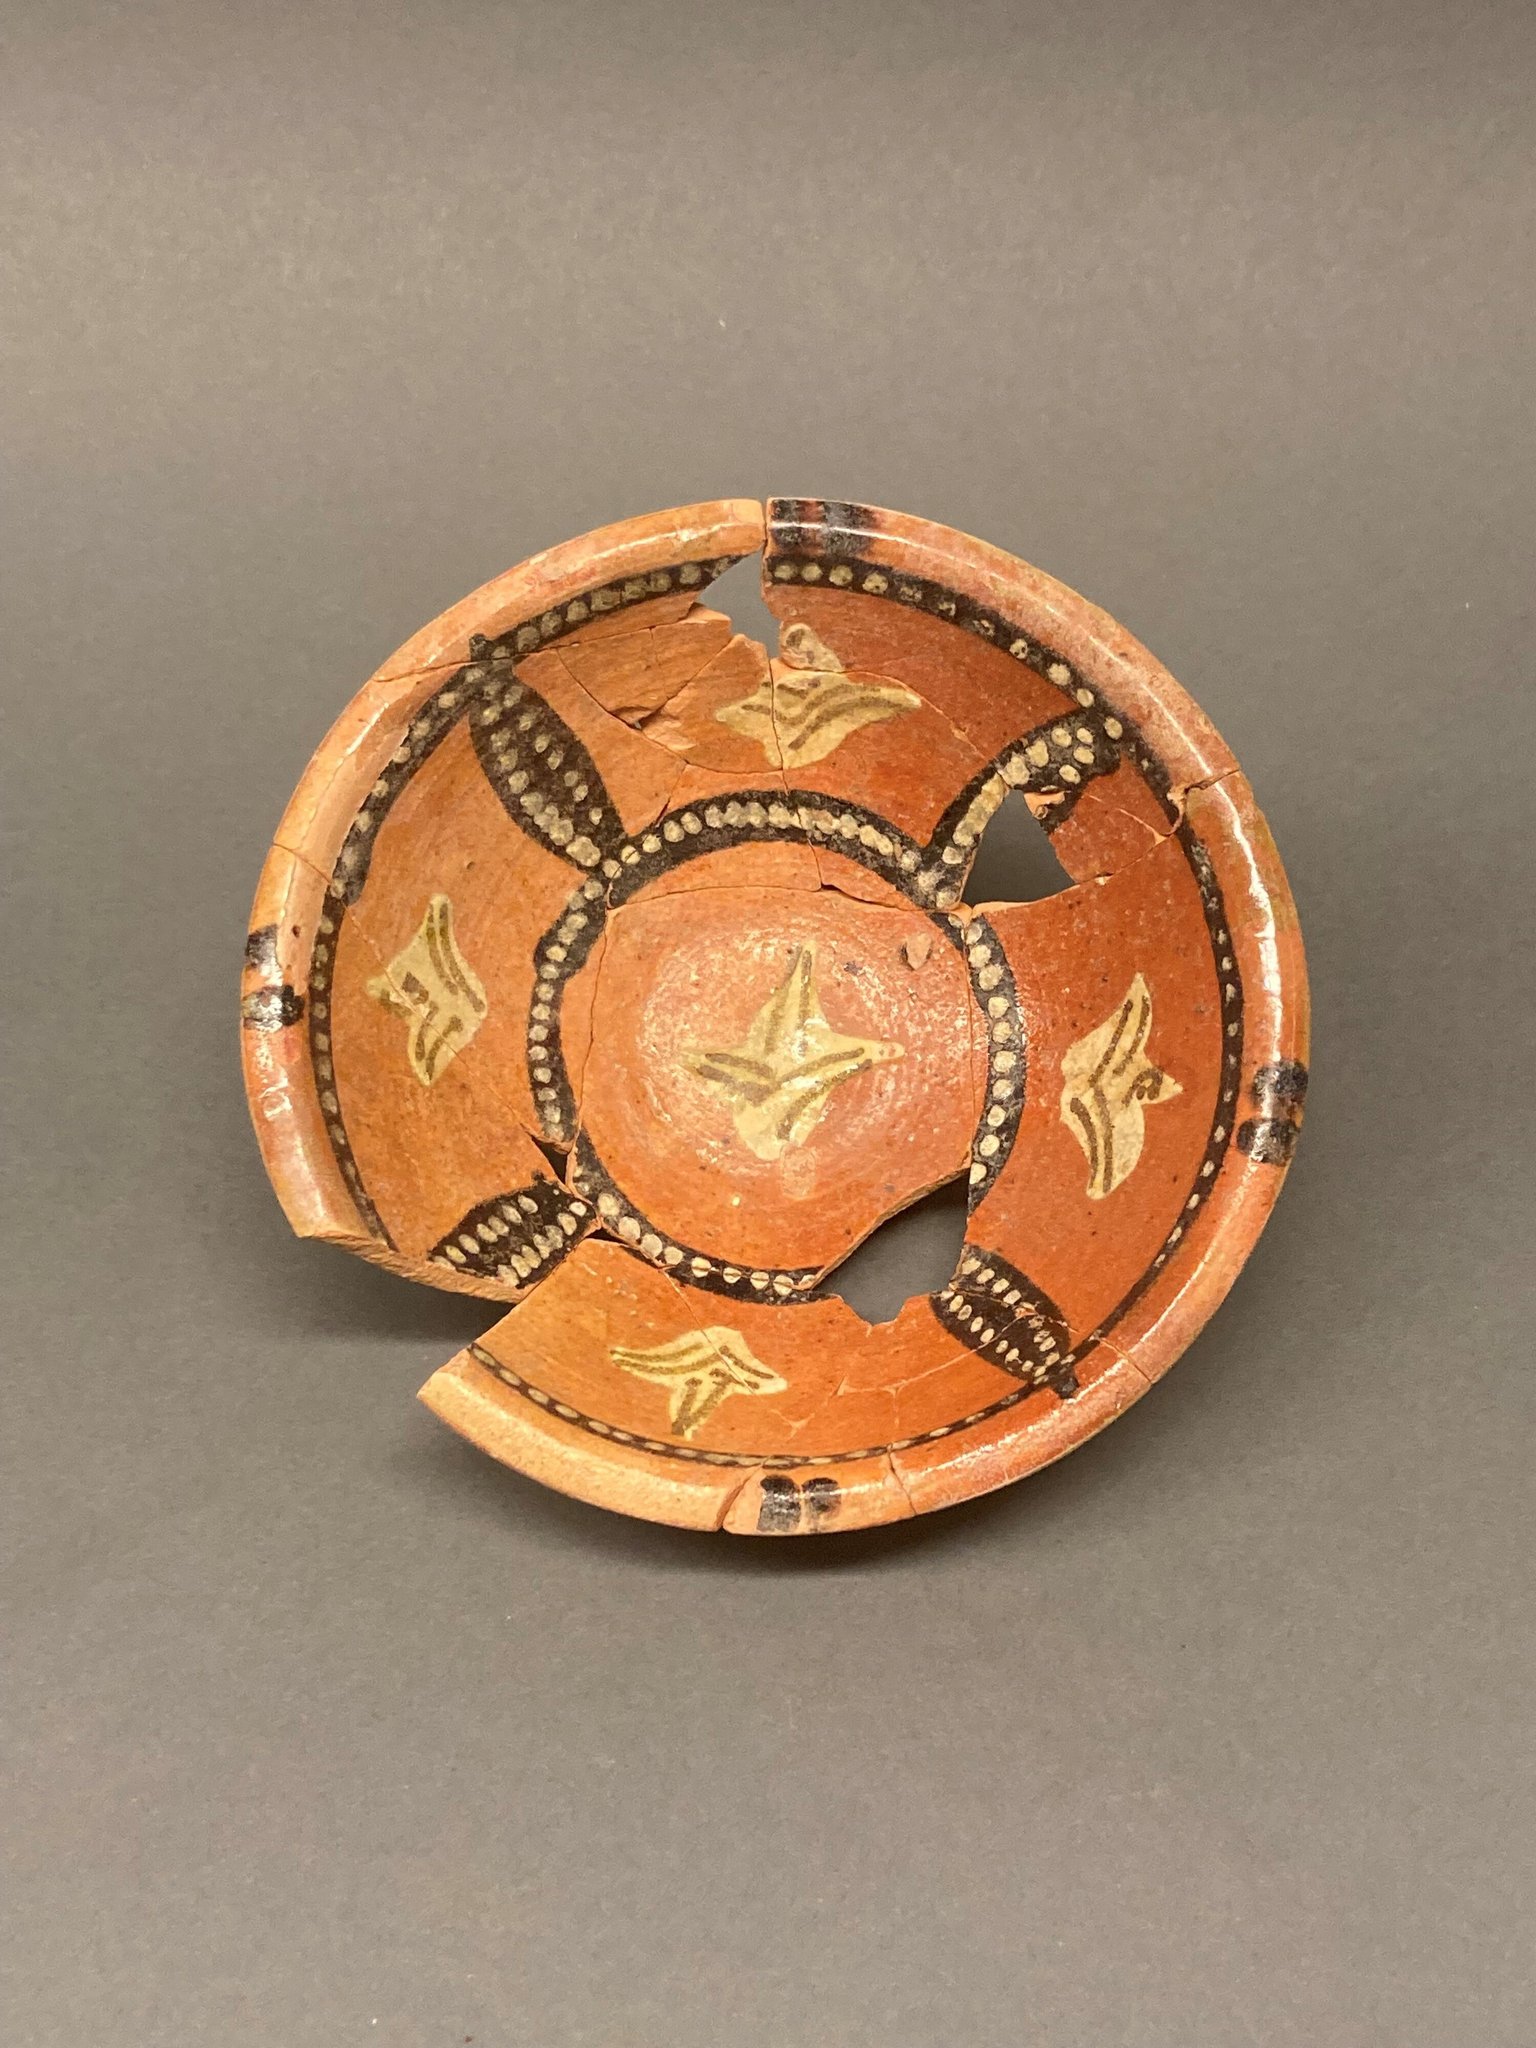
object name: bowl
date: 801-1000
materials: earthenware, glaze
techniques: polychrome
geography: iran